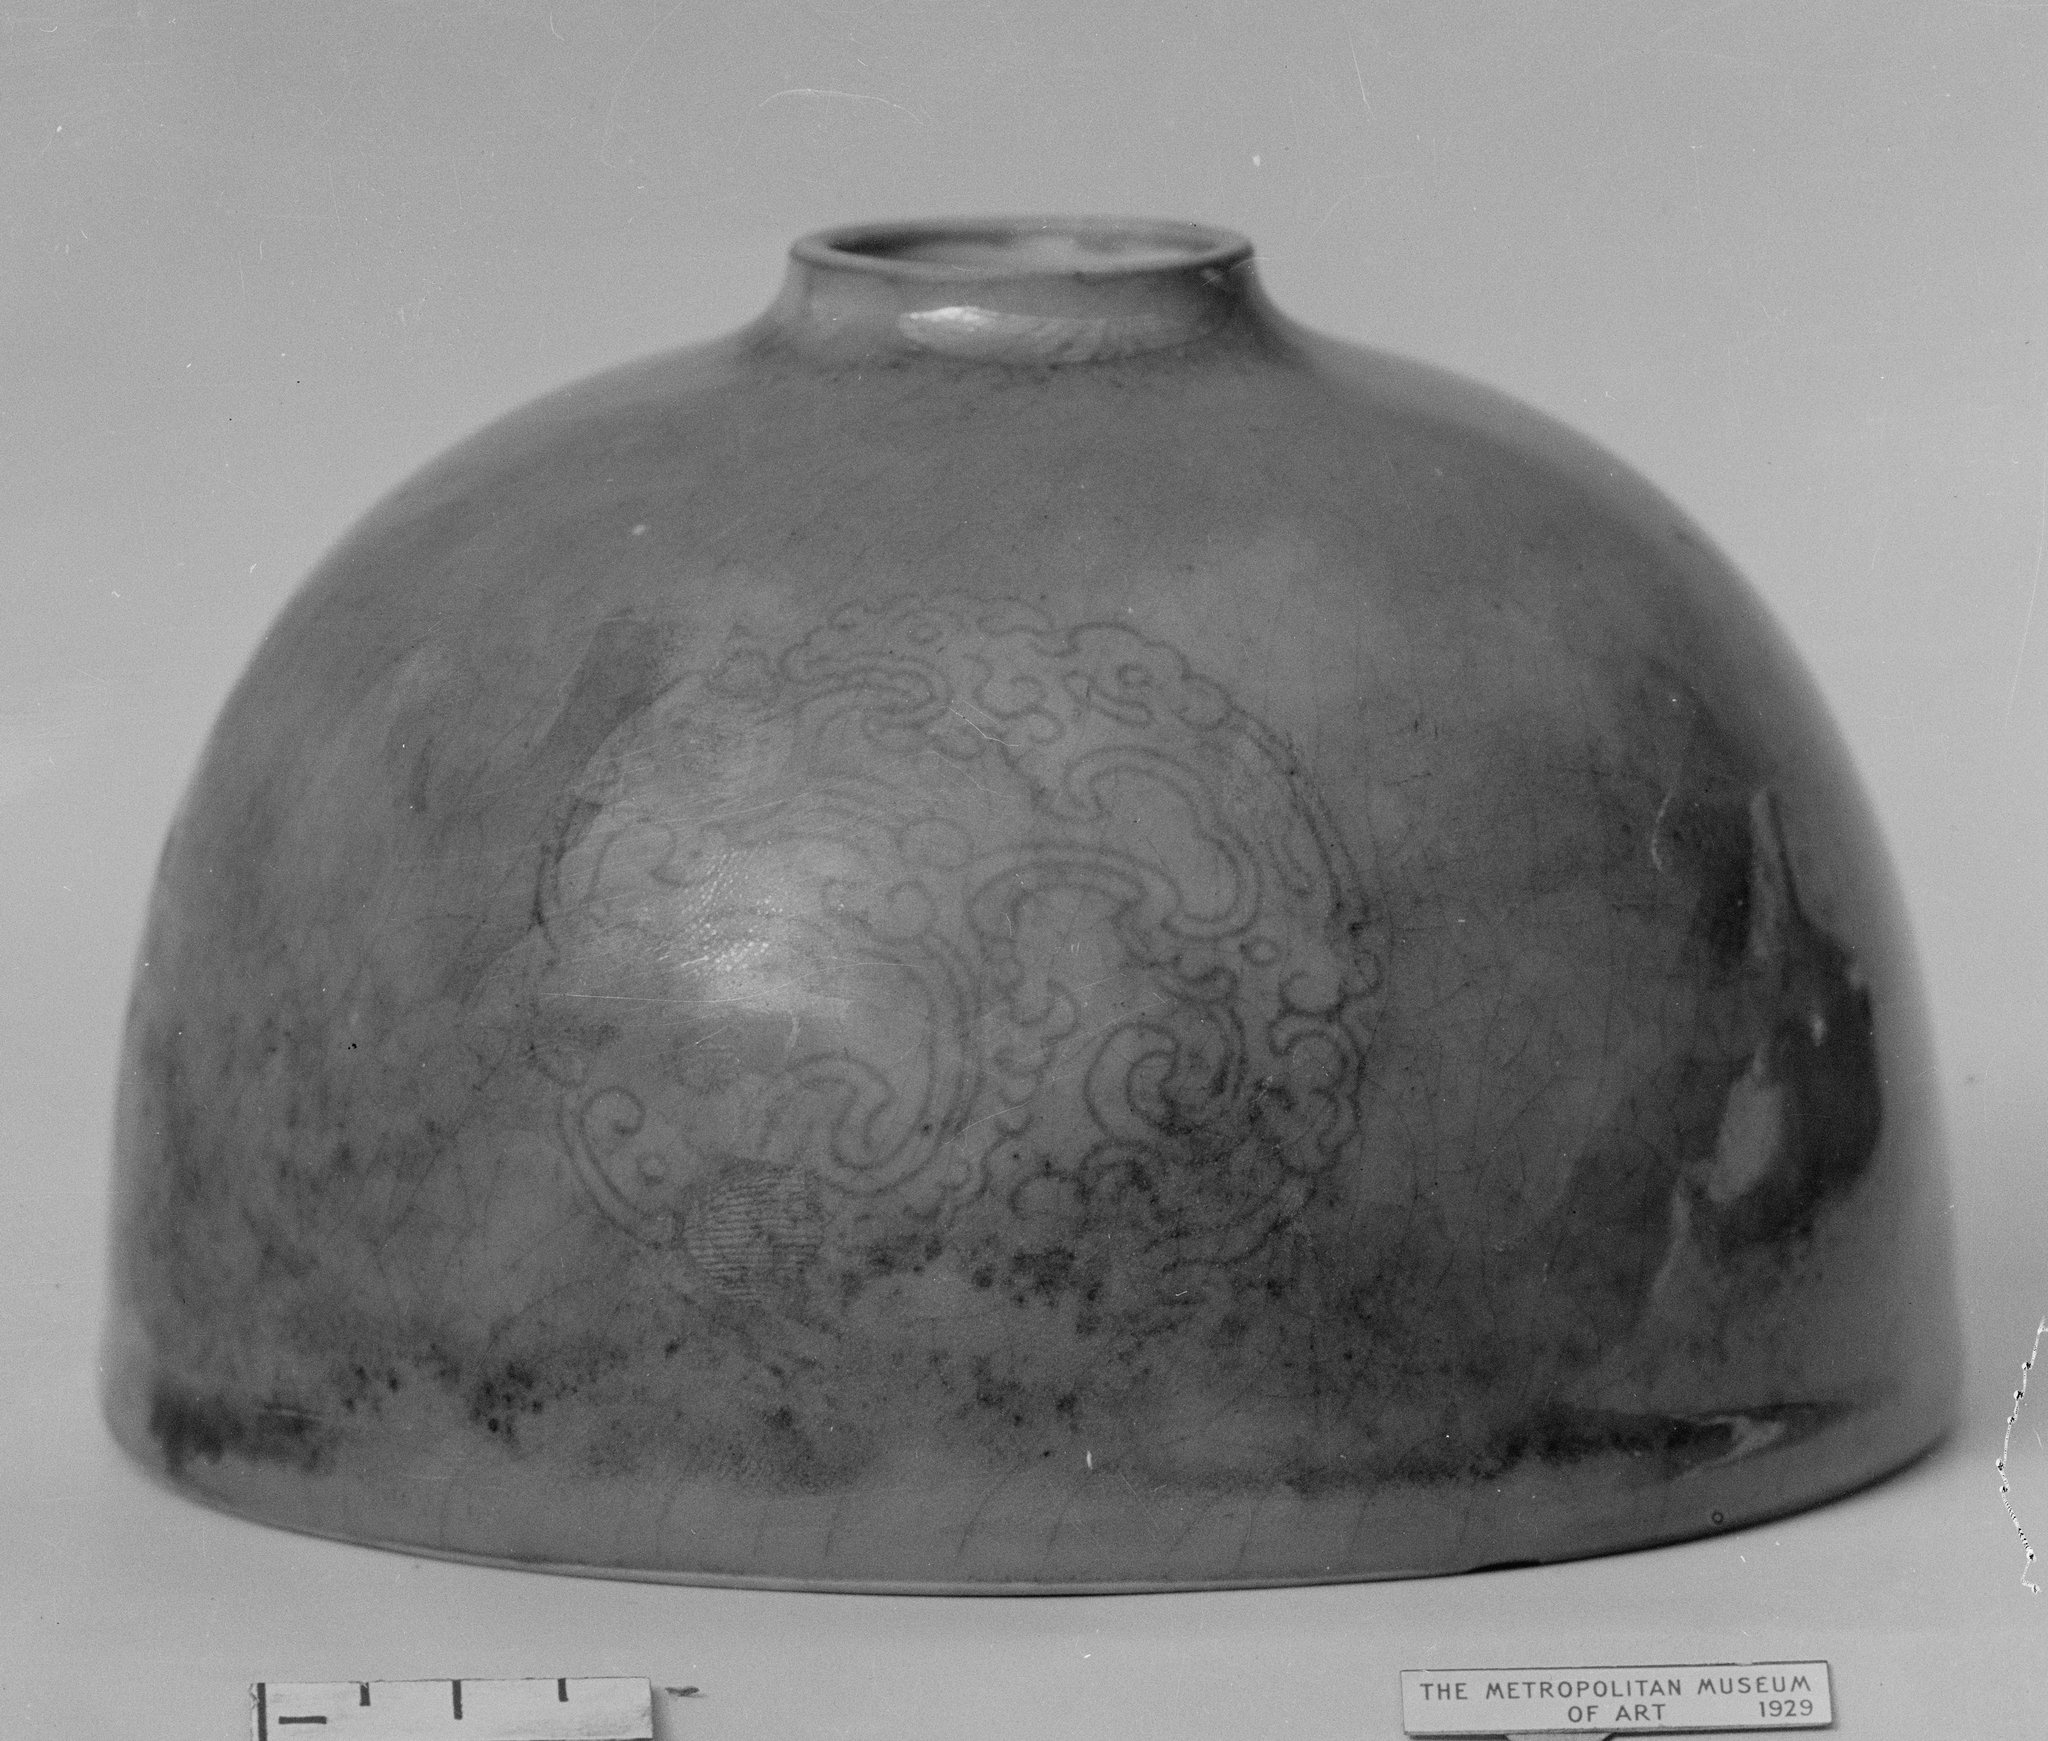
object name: water coupe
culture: chinese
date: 1662-1722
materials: glaze, porcelain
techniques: incising